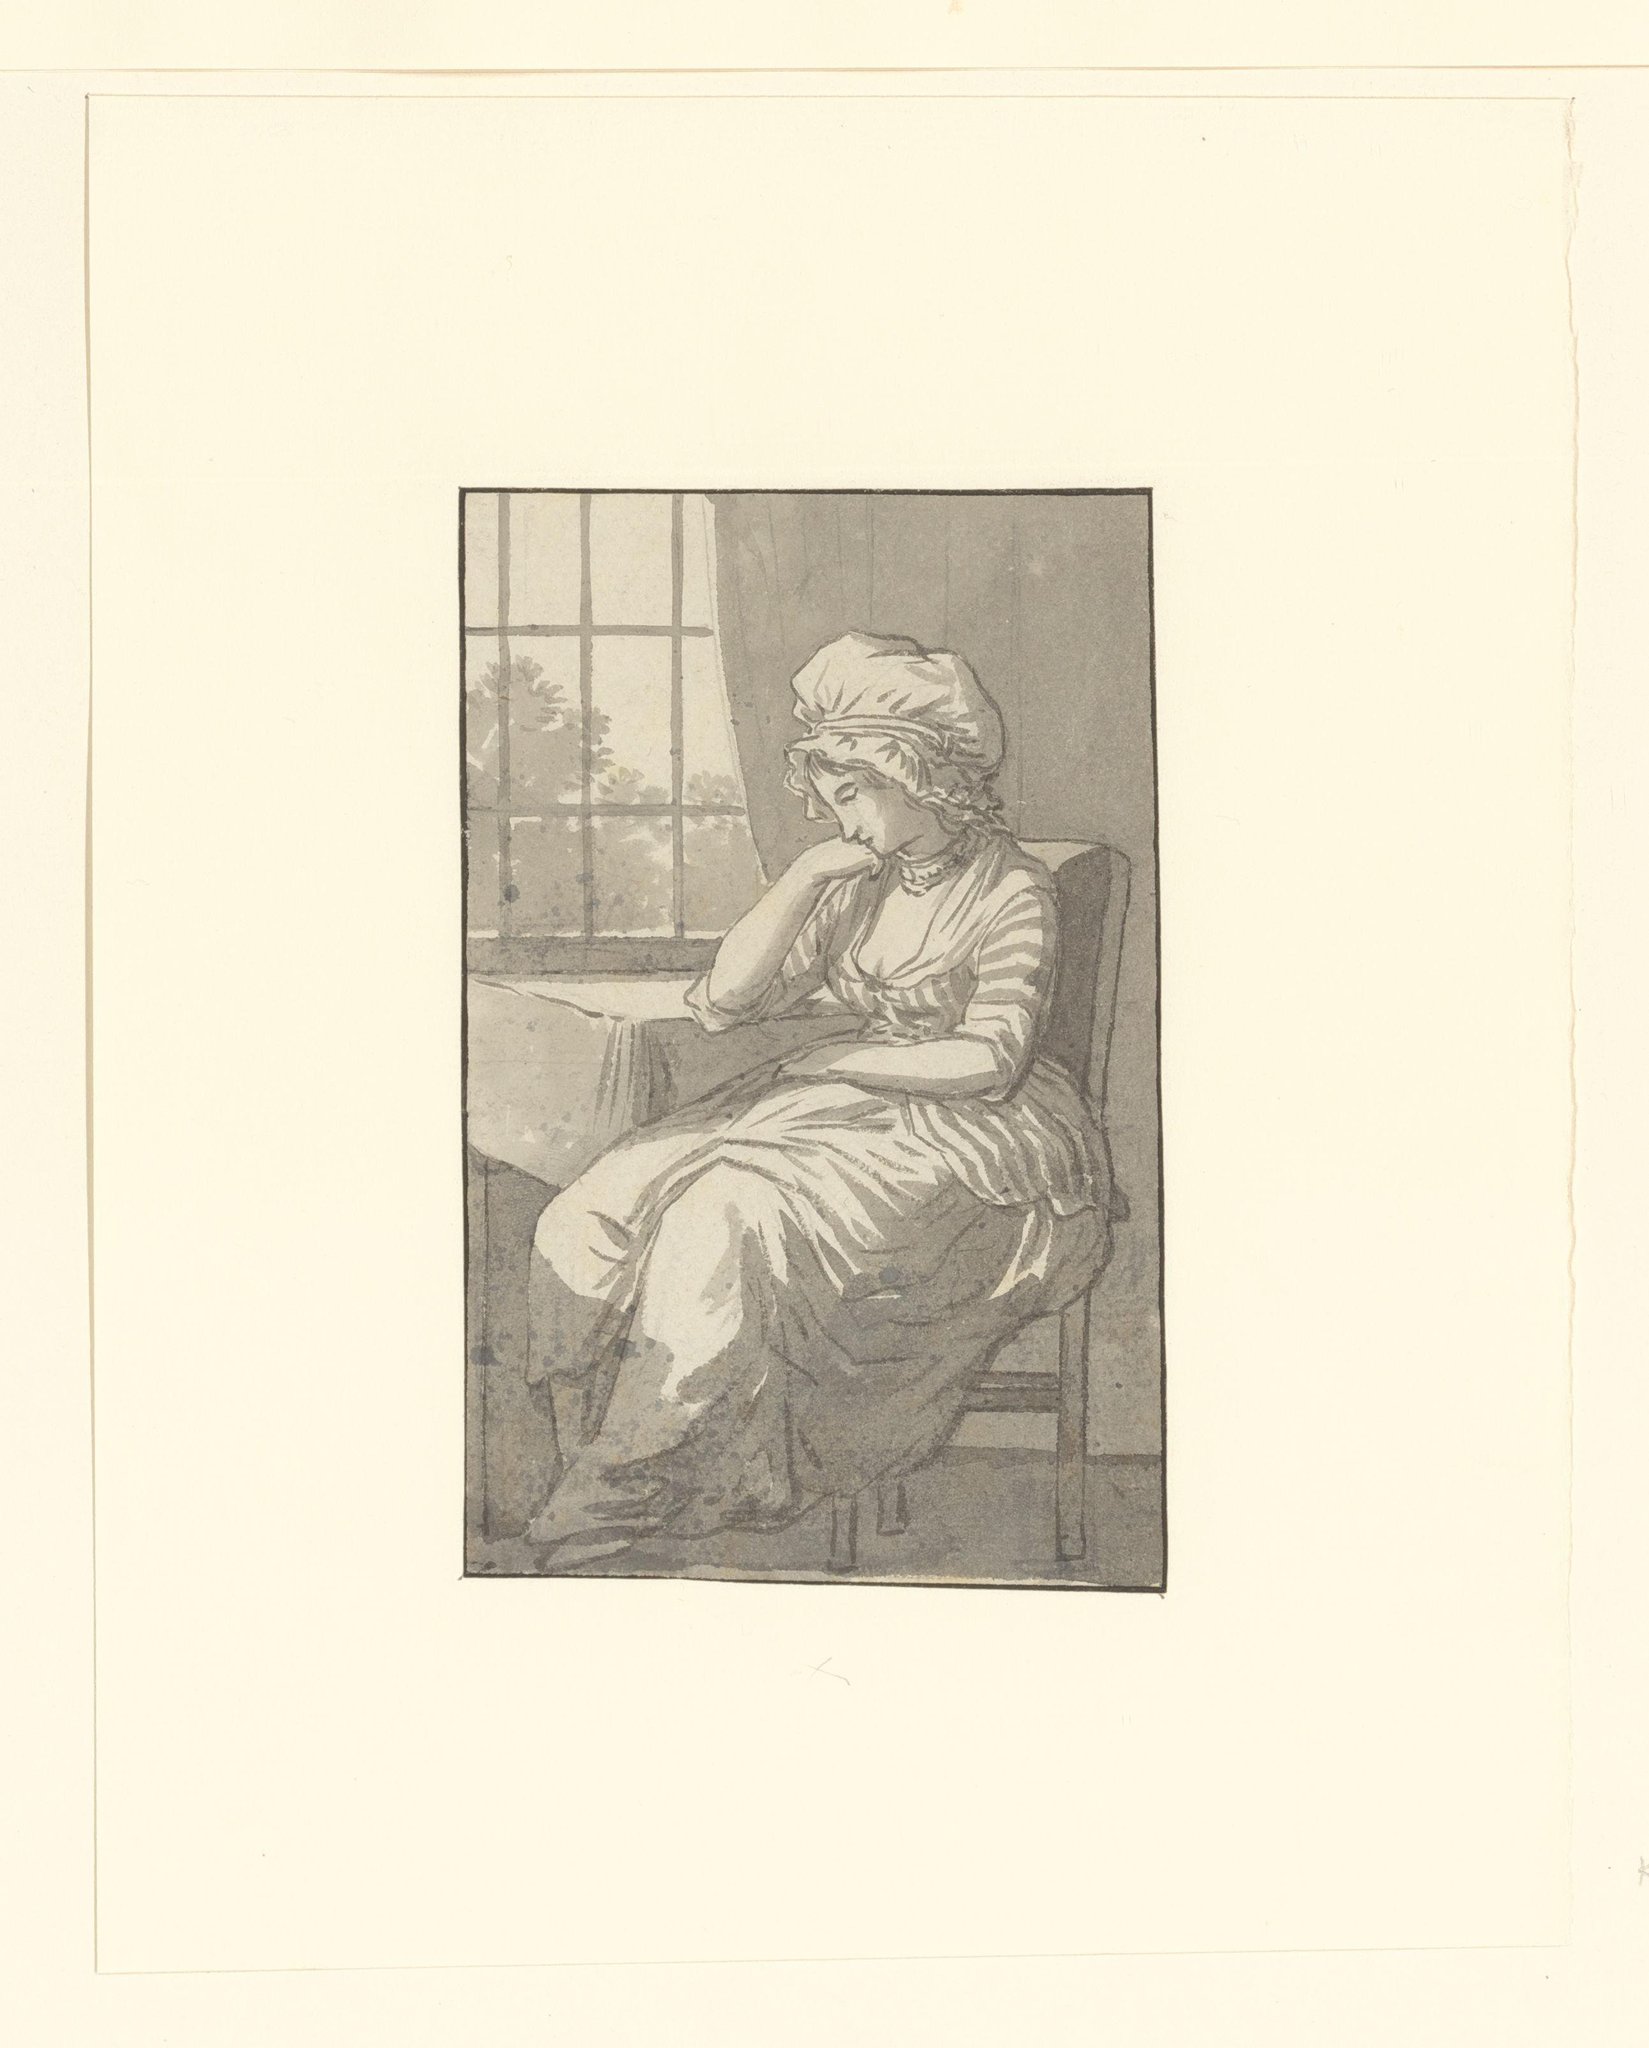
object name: drawing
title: Zittende Cornelia Aletta Hulst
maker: christiaan andriessen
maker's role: draughtsman, print maker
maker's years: 1775-1846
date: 1800-1810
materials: ink, paper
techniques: brush, pen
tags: sitting figure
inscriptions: collector's mark: Lugt 1641, collector's mark: Lugt 1641a